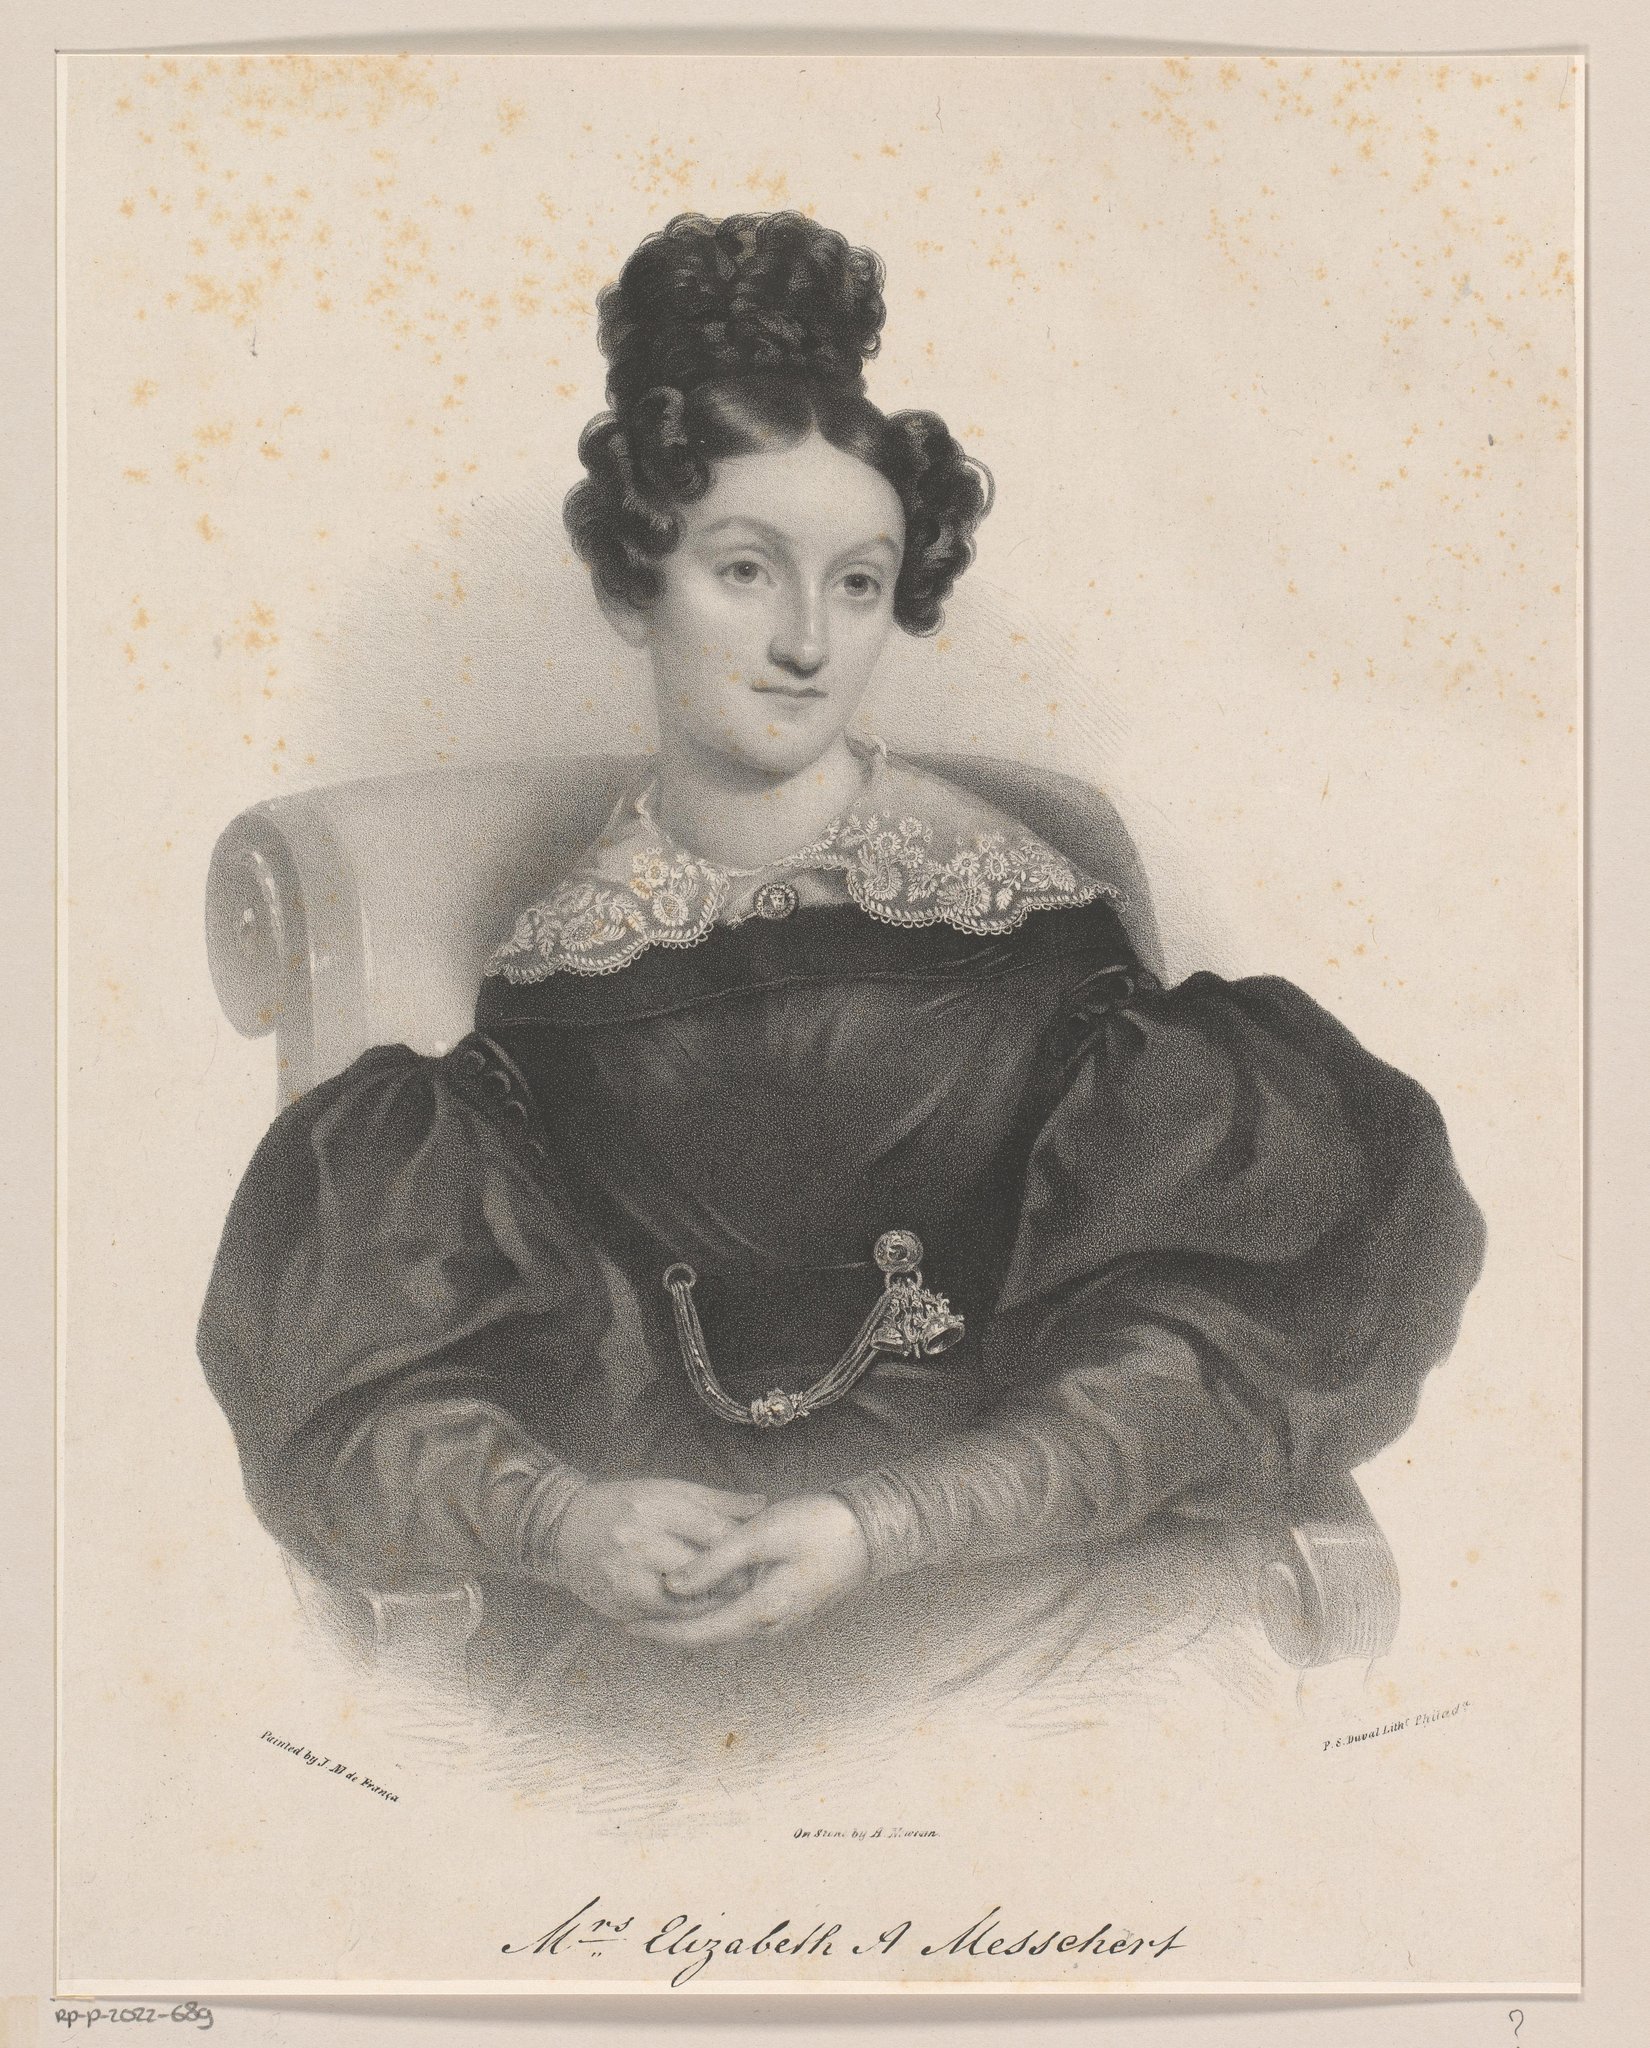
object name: print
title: Portret van Elisabeth Albertine Messchert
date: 1831-1864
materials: paper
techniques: lithograph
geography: philadelphia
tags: historical persons - bb - woman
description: Met facsimile signatuur van de geportretteerde.